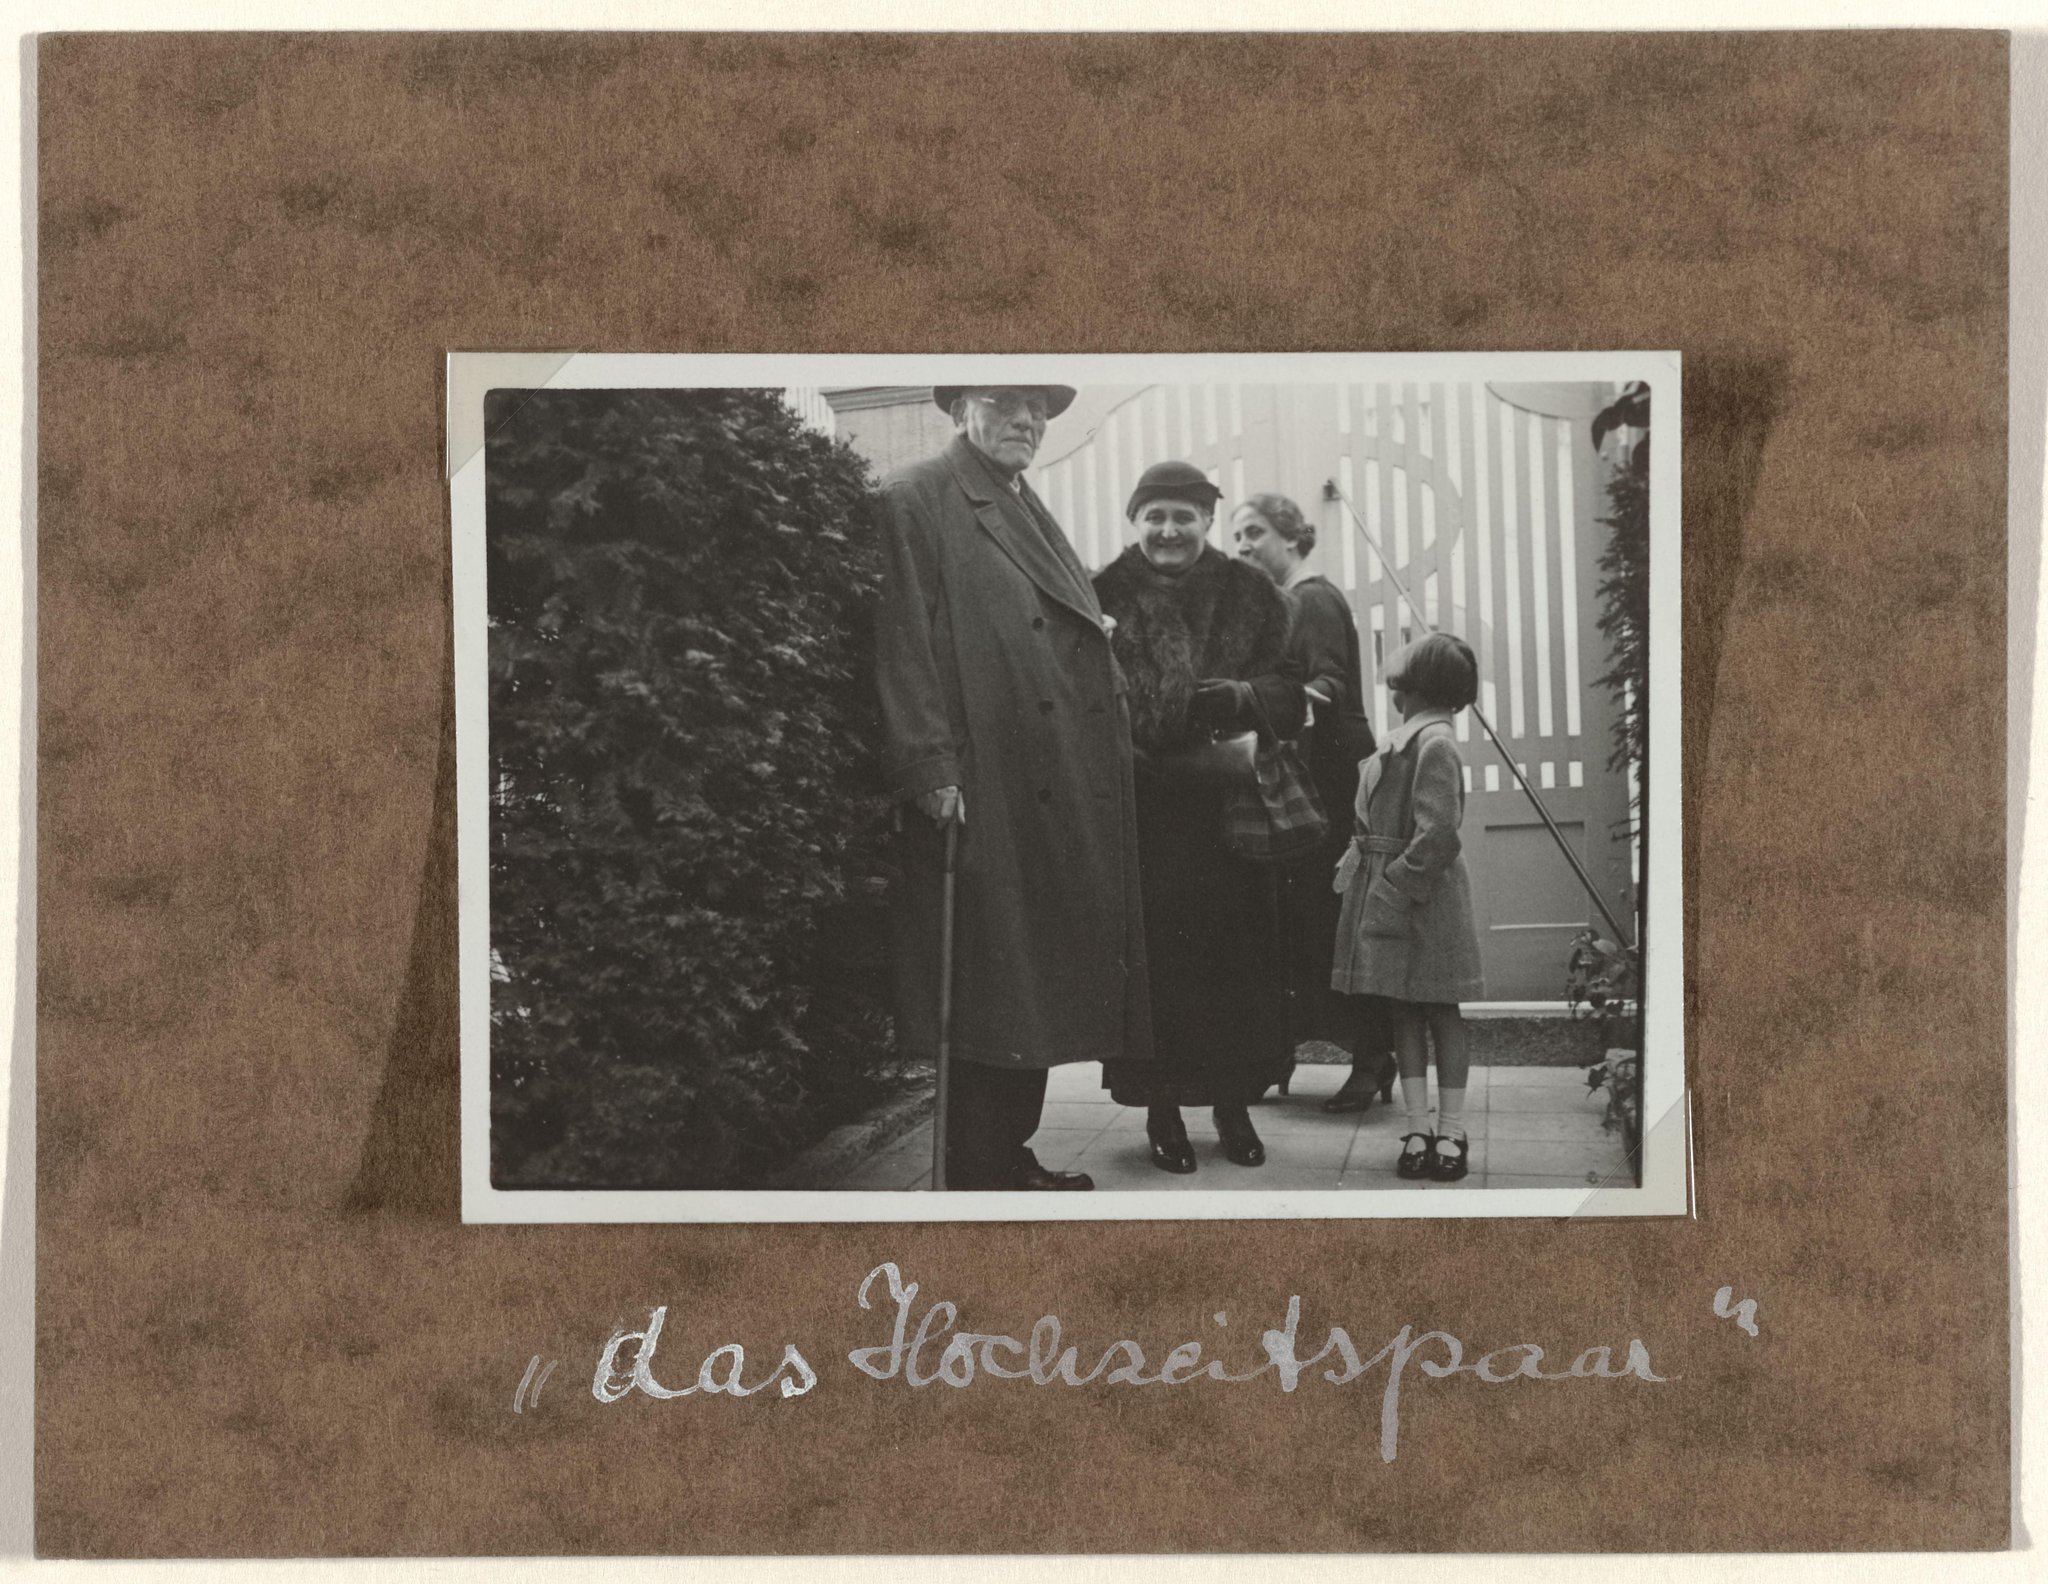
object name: photograph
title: Meir Wachenheimer, Mathilde Wachenheimer Moos, Else Wachenheimer en Isabel Wachenheimer op gouden huwelijksjubileum Meir en Mathilde, 22 oktober 1934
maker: Anonymous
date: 1934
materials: photographic support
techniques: gelatin silver print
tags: else wachenheimer-moos, isabel wachenheimer-elon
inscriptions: date: ‘,,das Hochzeitspaar''’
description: Dit object is onderdeel van de nalatenschap van Isabel Elon-Wachenheimer (1928-2010). Tot haar overlijden behoorde het samen met de andere objecten uit de nalatenschap tot haar privédomein van Isabel Wachenheimer. In die particuliere context zijn deze objecten tezamen en individueel aandenkens - aan de jeugd, ouders en familie van Isabel Wachenheimer vóór en tijdens de Shoah en aan haar leven na de Tweede Wereldoorlog. Isabel Wachenheimer, die van juni 1943 tot mei 1945 gevangen zat in Kamp Westerbork, Theresienstadt, Auschwitz, Lenzing a/d Oberdonau (een buitenkamp van Mauthausen), overleefde de Shoah. Haar ouders – Eugène Wachenheimer en Else Wachenheimer-Moos - werden op 14 oktober 1944 in Auschwitz-Birkenau vermoord.